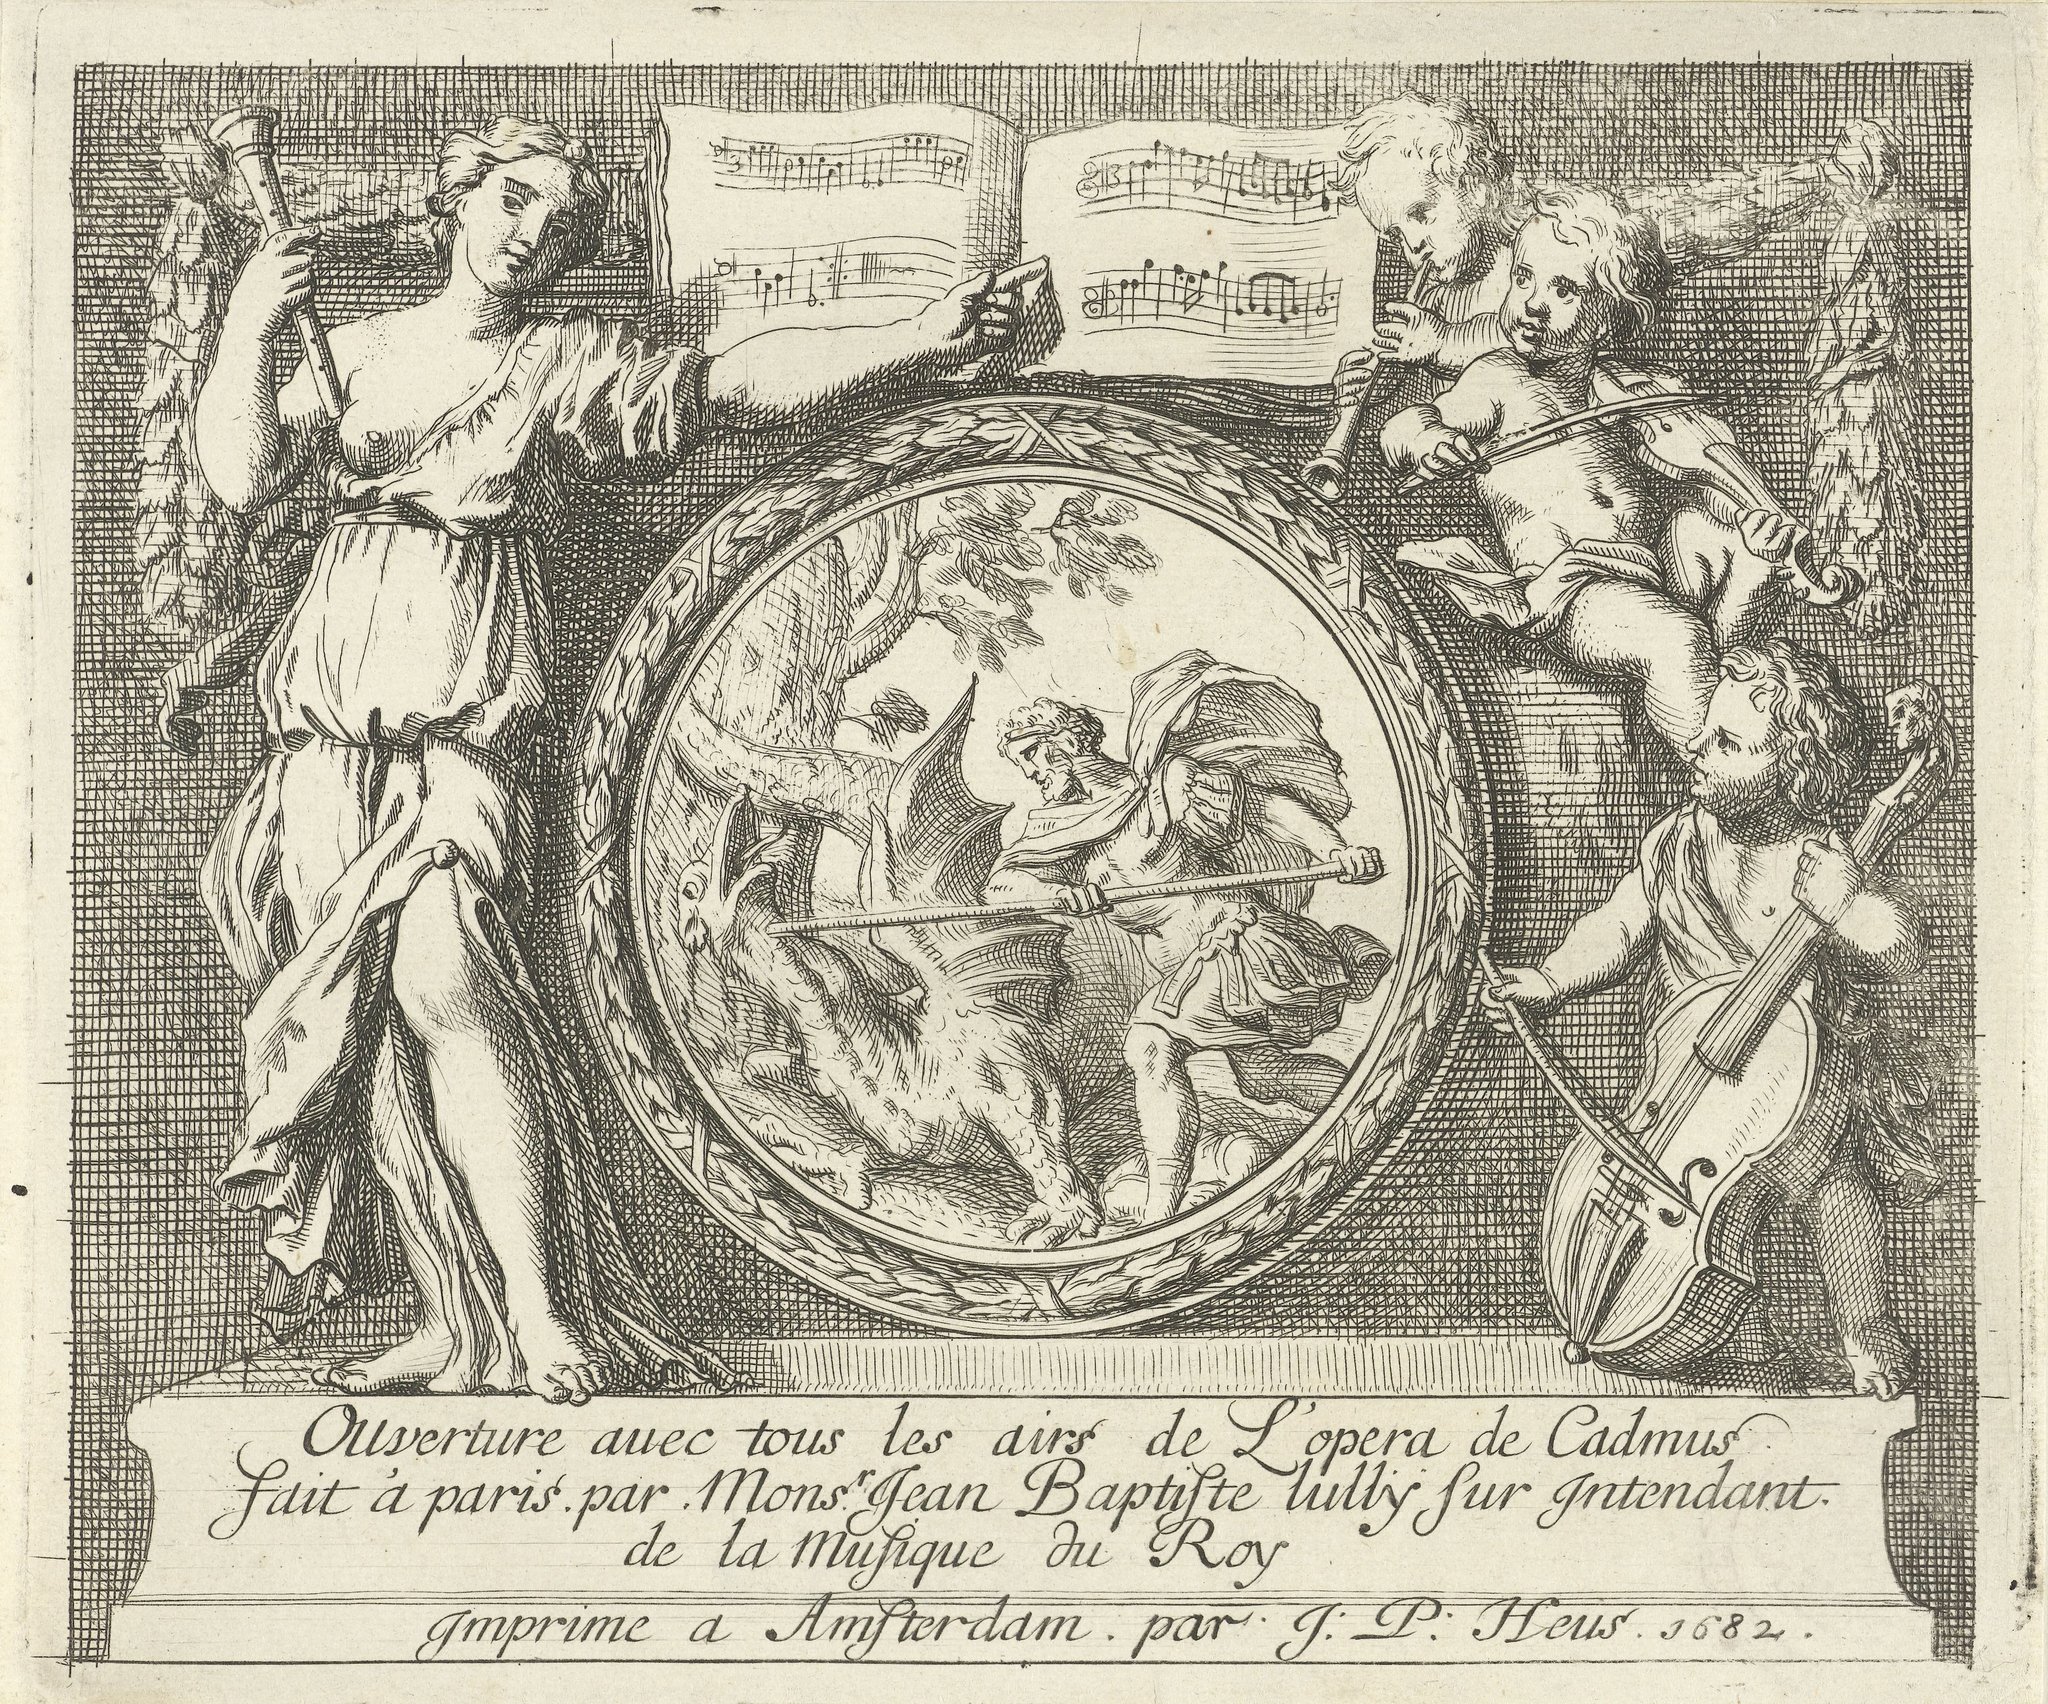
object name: print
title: Cadmus doodt de draak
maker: jean philip heus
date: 1682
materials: paper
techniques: etching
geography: amsterdam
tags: musical instruments; group of musical instruments, cupids: 'amores', 'amoretti', 'putti', cadmus slays the dragon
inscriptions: collector's mark: Lugt 240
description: Cadmus doodt de draak die zijn metgezellen verslonden heeft. De mythologische voorstelling is gevat in een medaillonvormige lijst. Links hiervan wijst een allegorische vrouwfiguur met een fluit op bladmuziek boven de lijst, rechts bespelen drie putti verschillende instrumenten. Onderin de prent staat een drieregelig onderschrift in het Frans.